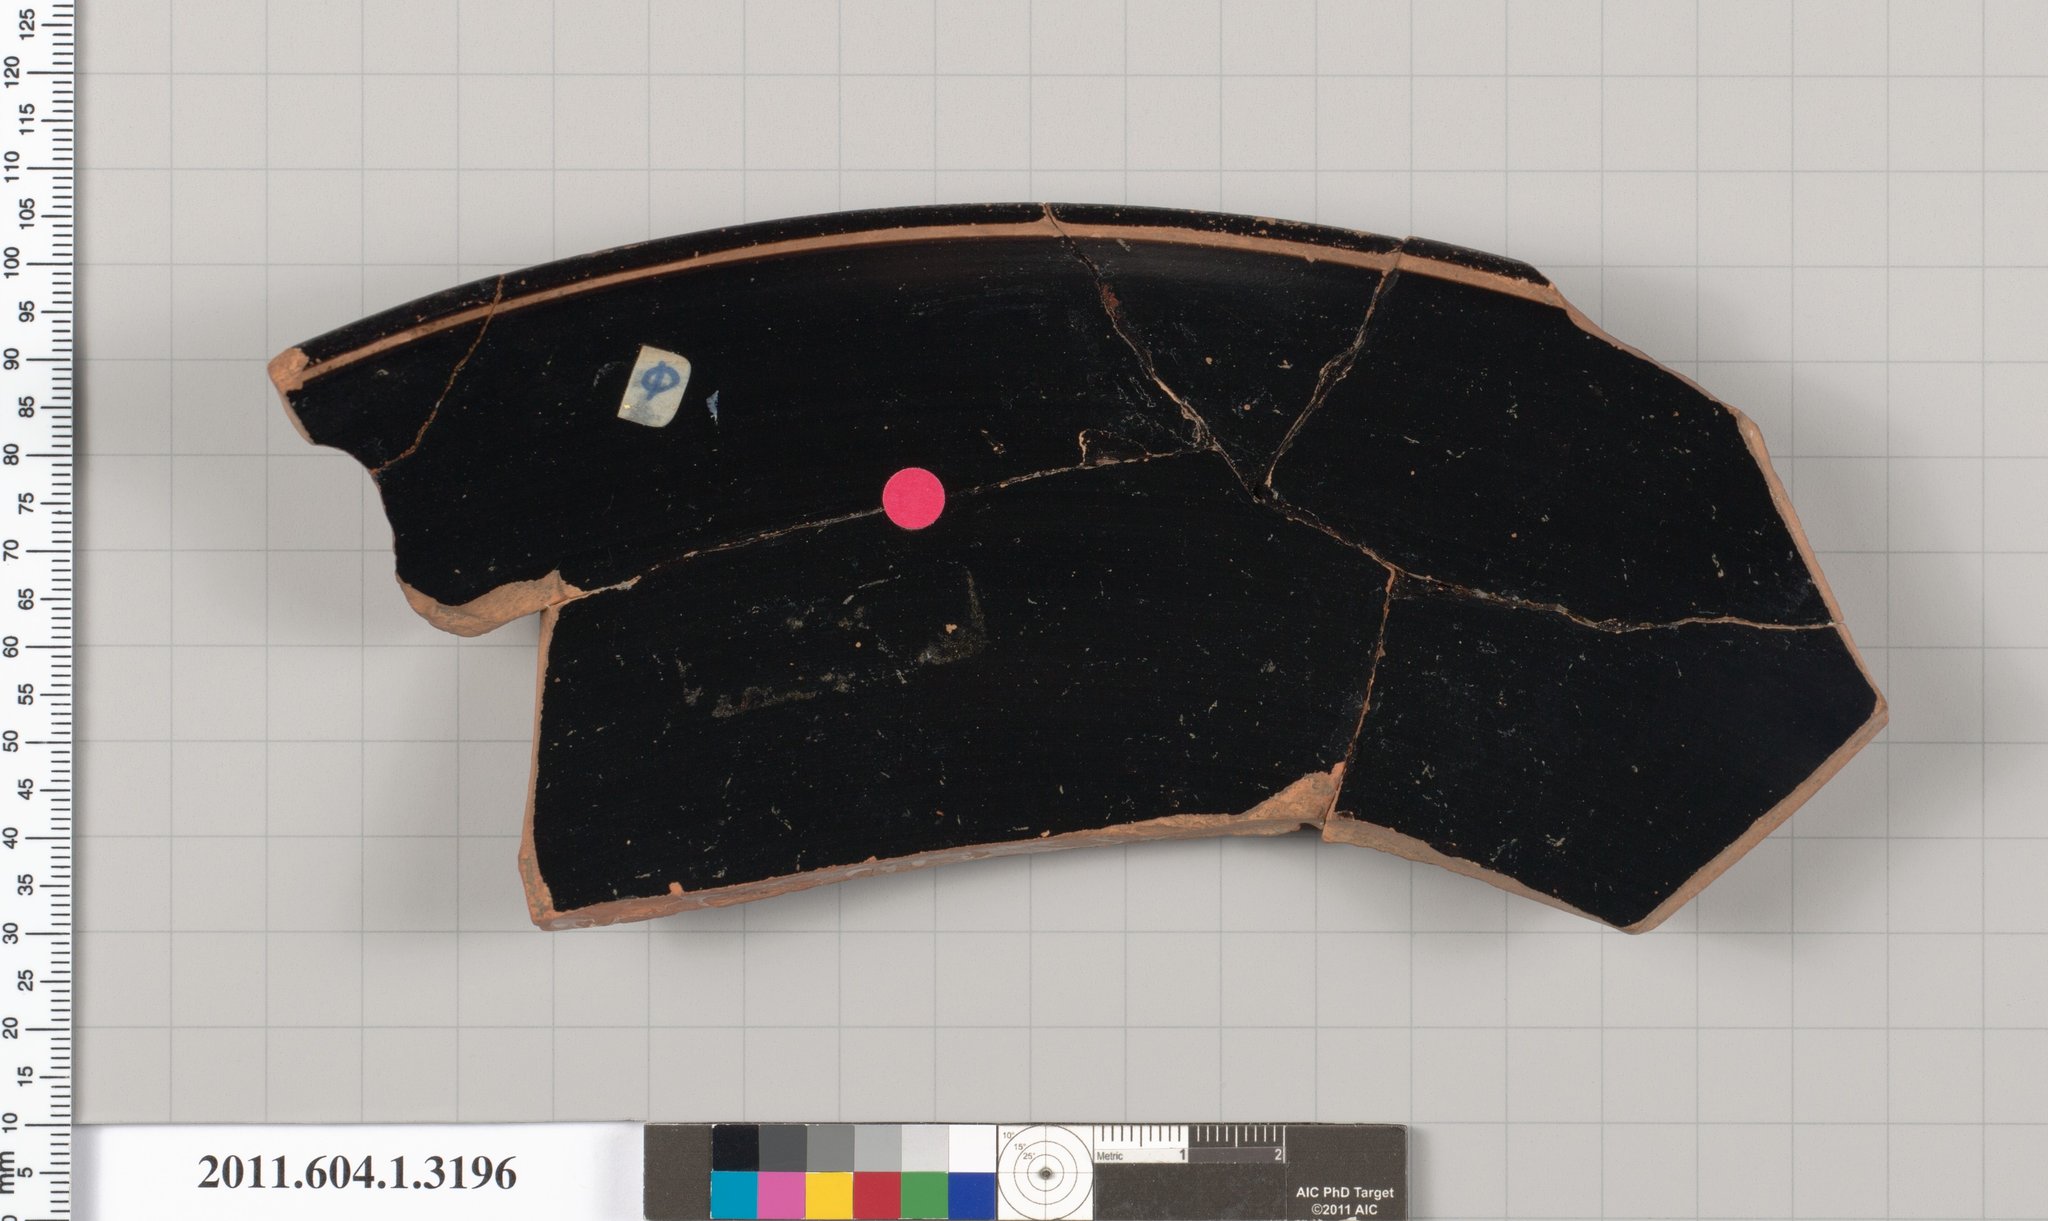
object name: kylix fragment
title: Terracotta rim fragment of a kylix (drinking cup)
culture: greek, attic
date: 525-500 BCE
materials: terracotta